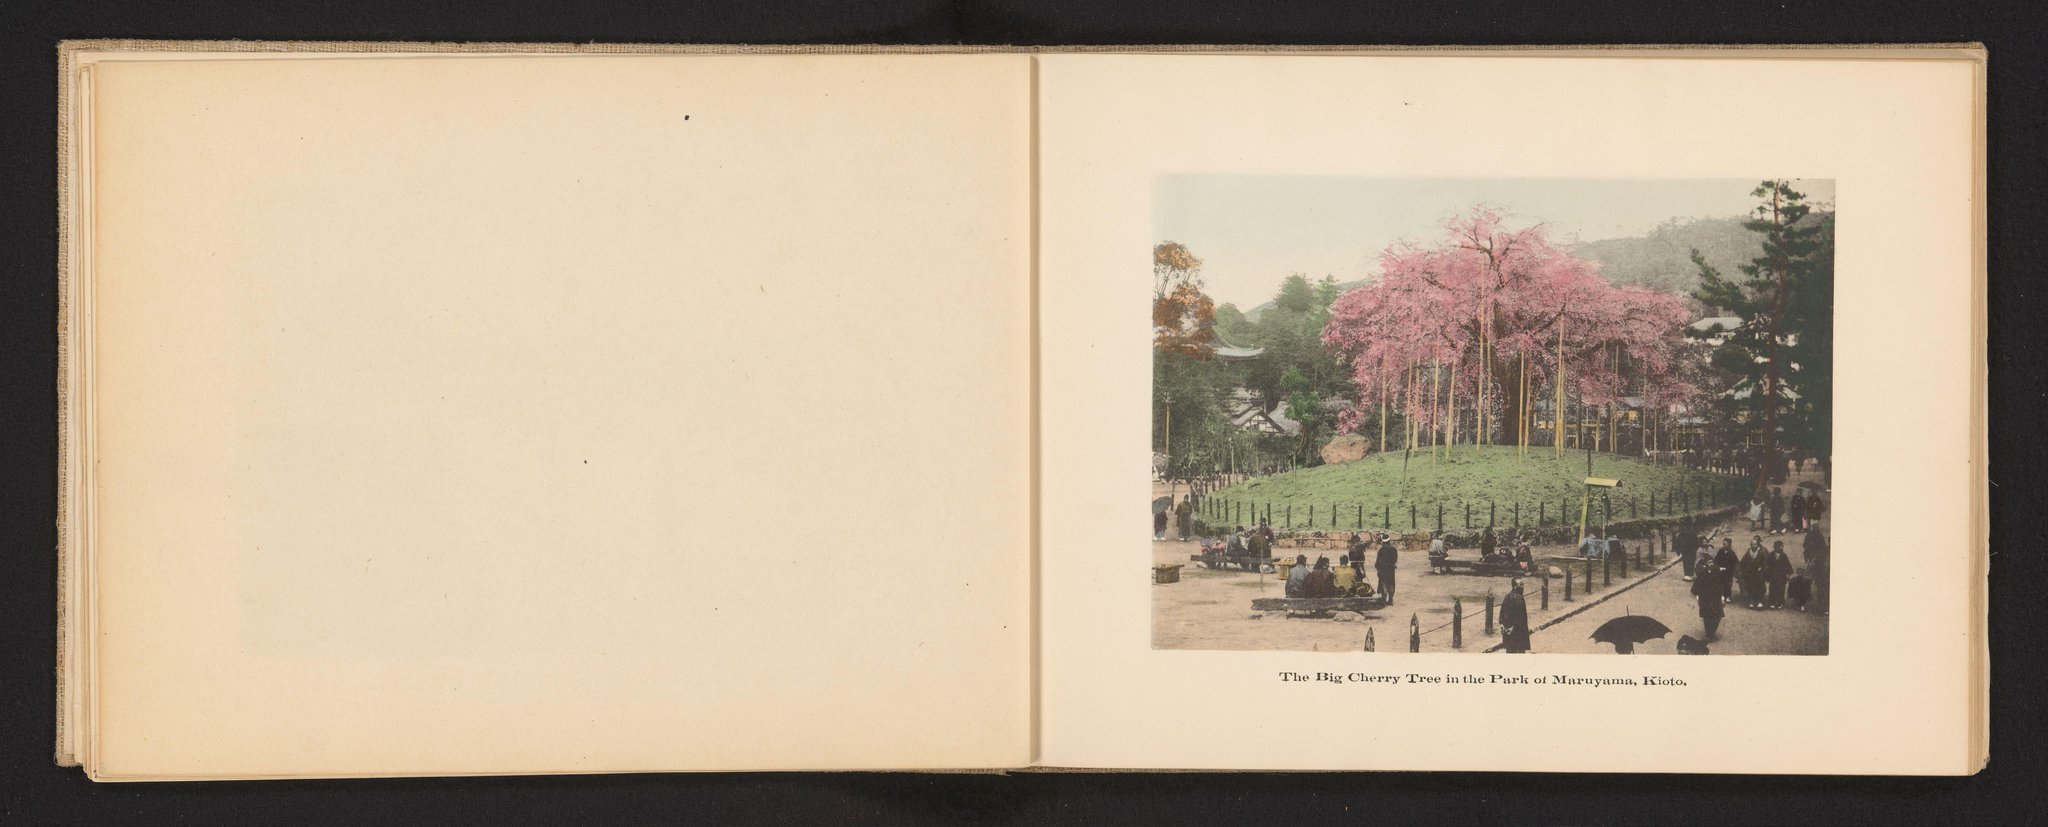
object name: photomechanical print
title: The Big Cherry Tree in the Park of Maruyama, Kioto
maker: kōzaburō tamamura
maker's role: fotograaf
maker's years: 1856-1923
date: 1895-1905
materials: paper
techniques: photograph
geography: kyoto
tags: trees: cherry-tree, public gardens, park, kyoto